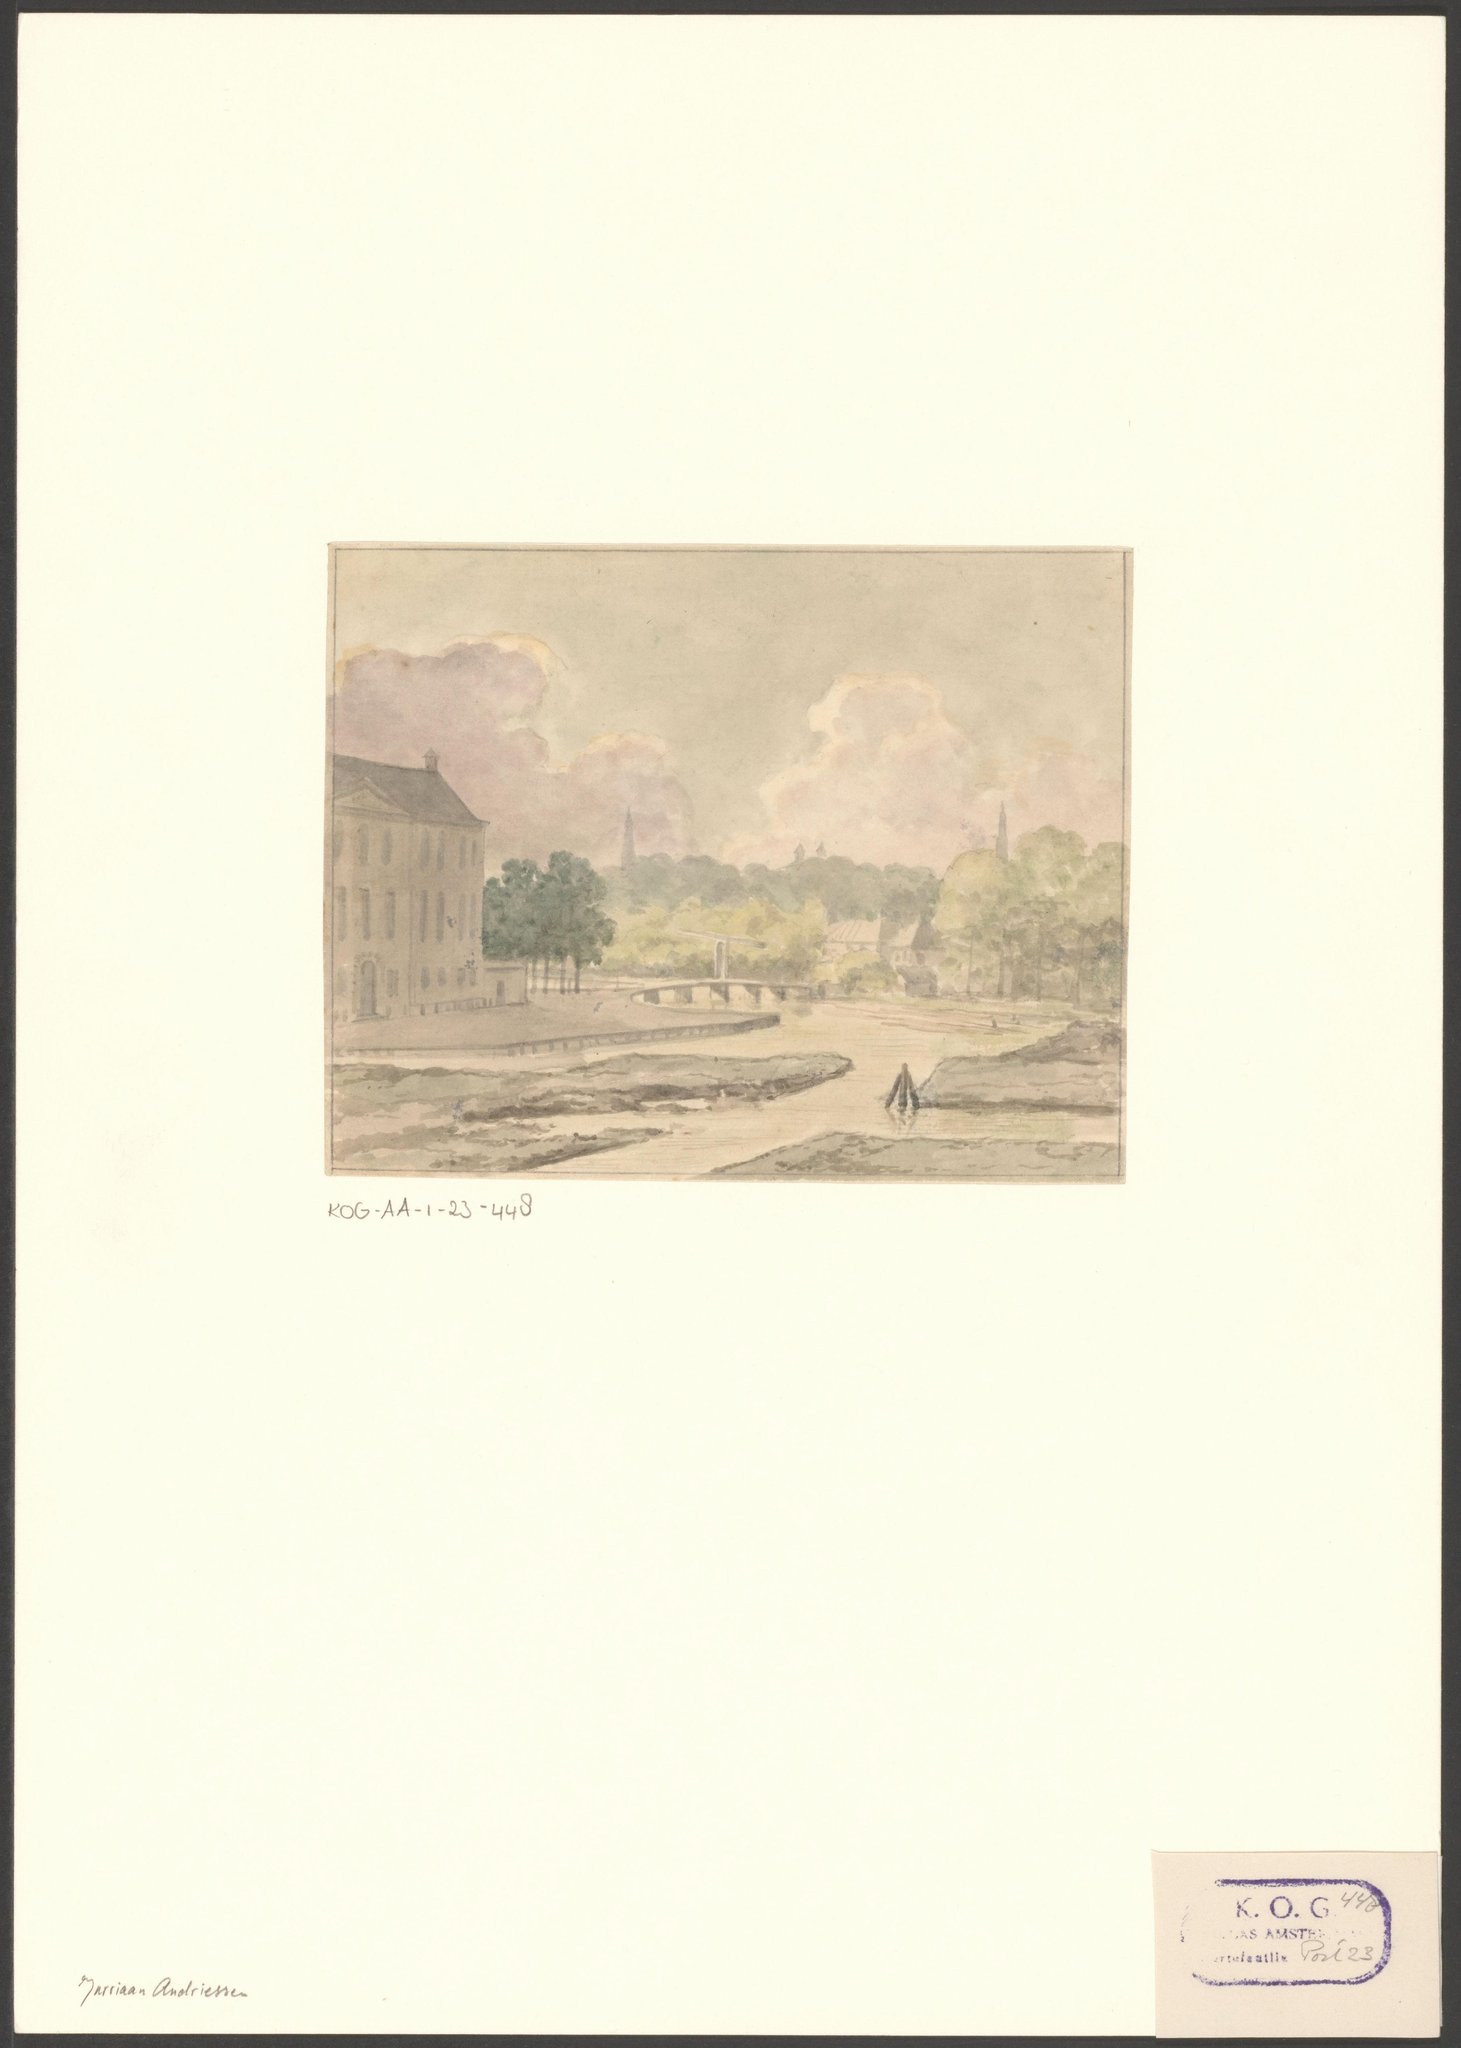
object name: drawing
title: Gezicht op het Nieuwe Werkhuis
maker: jurriaan andriessen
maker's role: draughtsman, painter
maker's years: 1742-1819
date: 1791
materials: paper, pencil, watercolor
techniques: brush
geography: amsterdam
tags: city-view in general; 'veduta', specialized institutions, canal, bridge in city across river, canal, etc.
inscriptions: collector's mark: ‘23’ Lugt 1641b, name: ‘Jurriaan Andriessen’, inscription: ‘Port. 23-448’, inscription: ‘gezicht op het nieuwe werkhuis / van de voorkant te zien / 1791’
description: Onderwerpsrubriek binnen de Atlas Amsterdam: Handvesten, Keuren, enz.; Rechtswezen (incl. gevangenissen, enz.).